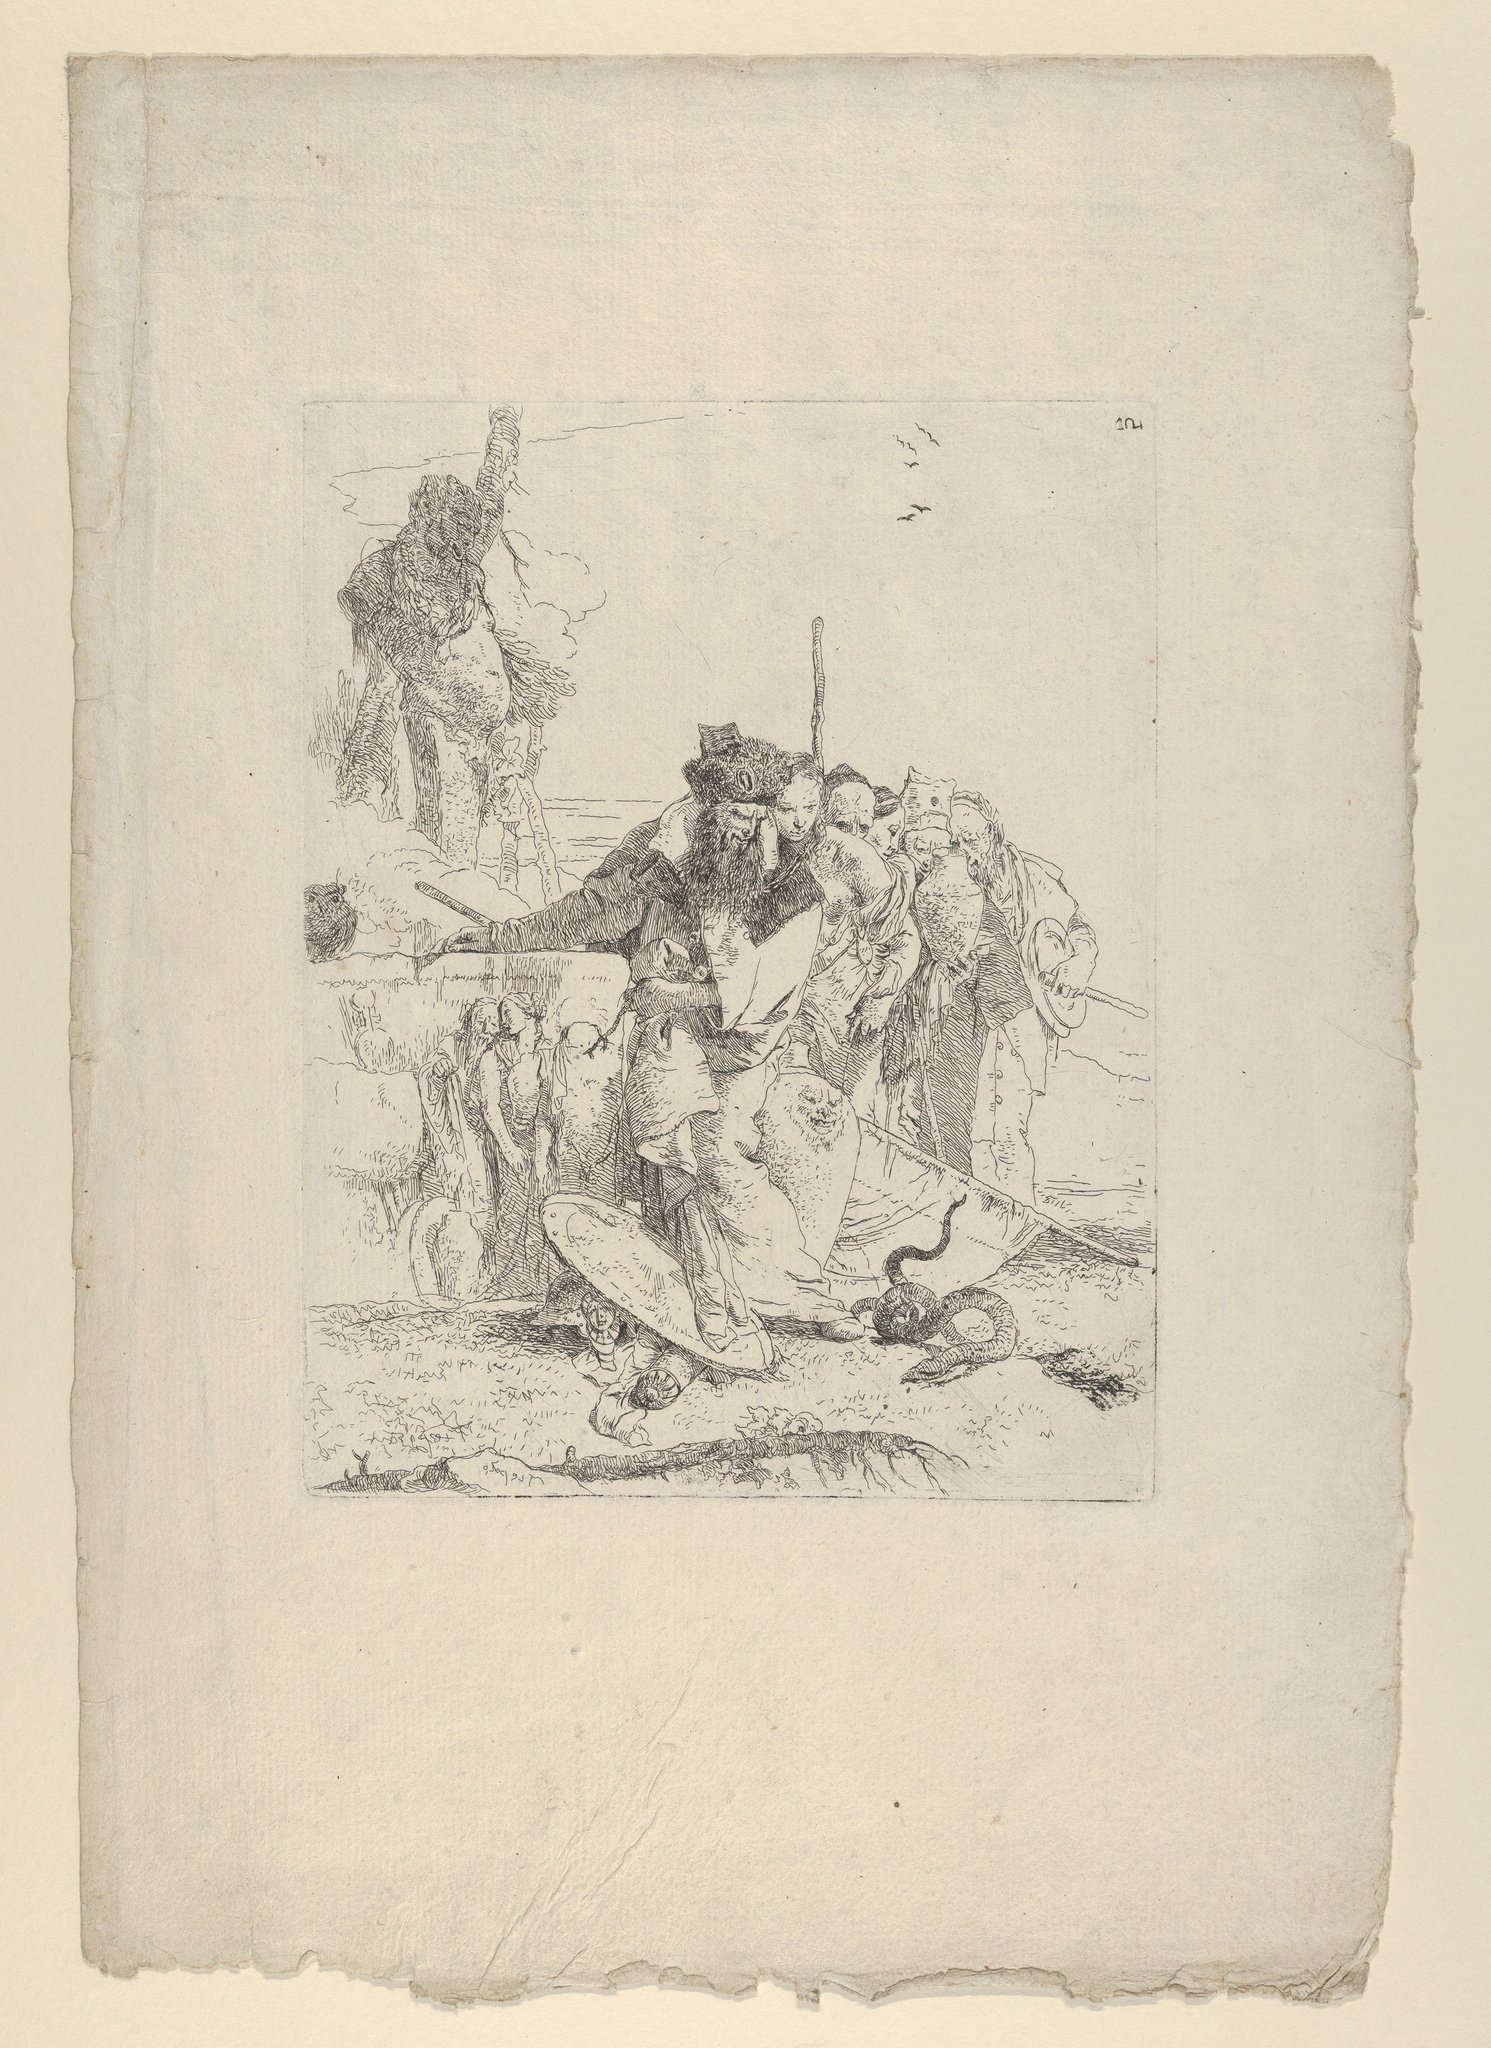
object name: print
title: Six people watching a snake, from the Scherzi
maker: giovanni battista tiepolo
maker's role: artist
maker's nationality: italian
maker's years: 1696-1770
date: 1743-1750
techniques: etching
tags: men,women,snakes